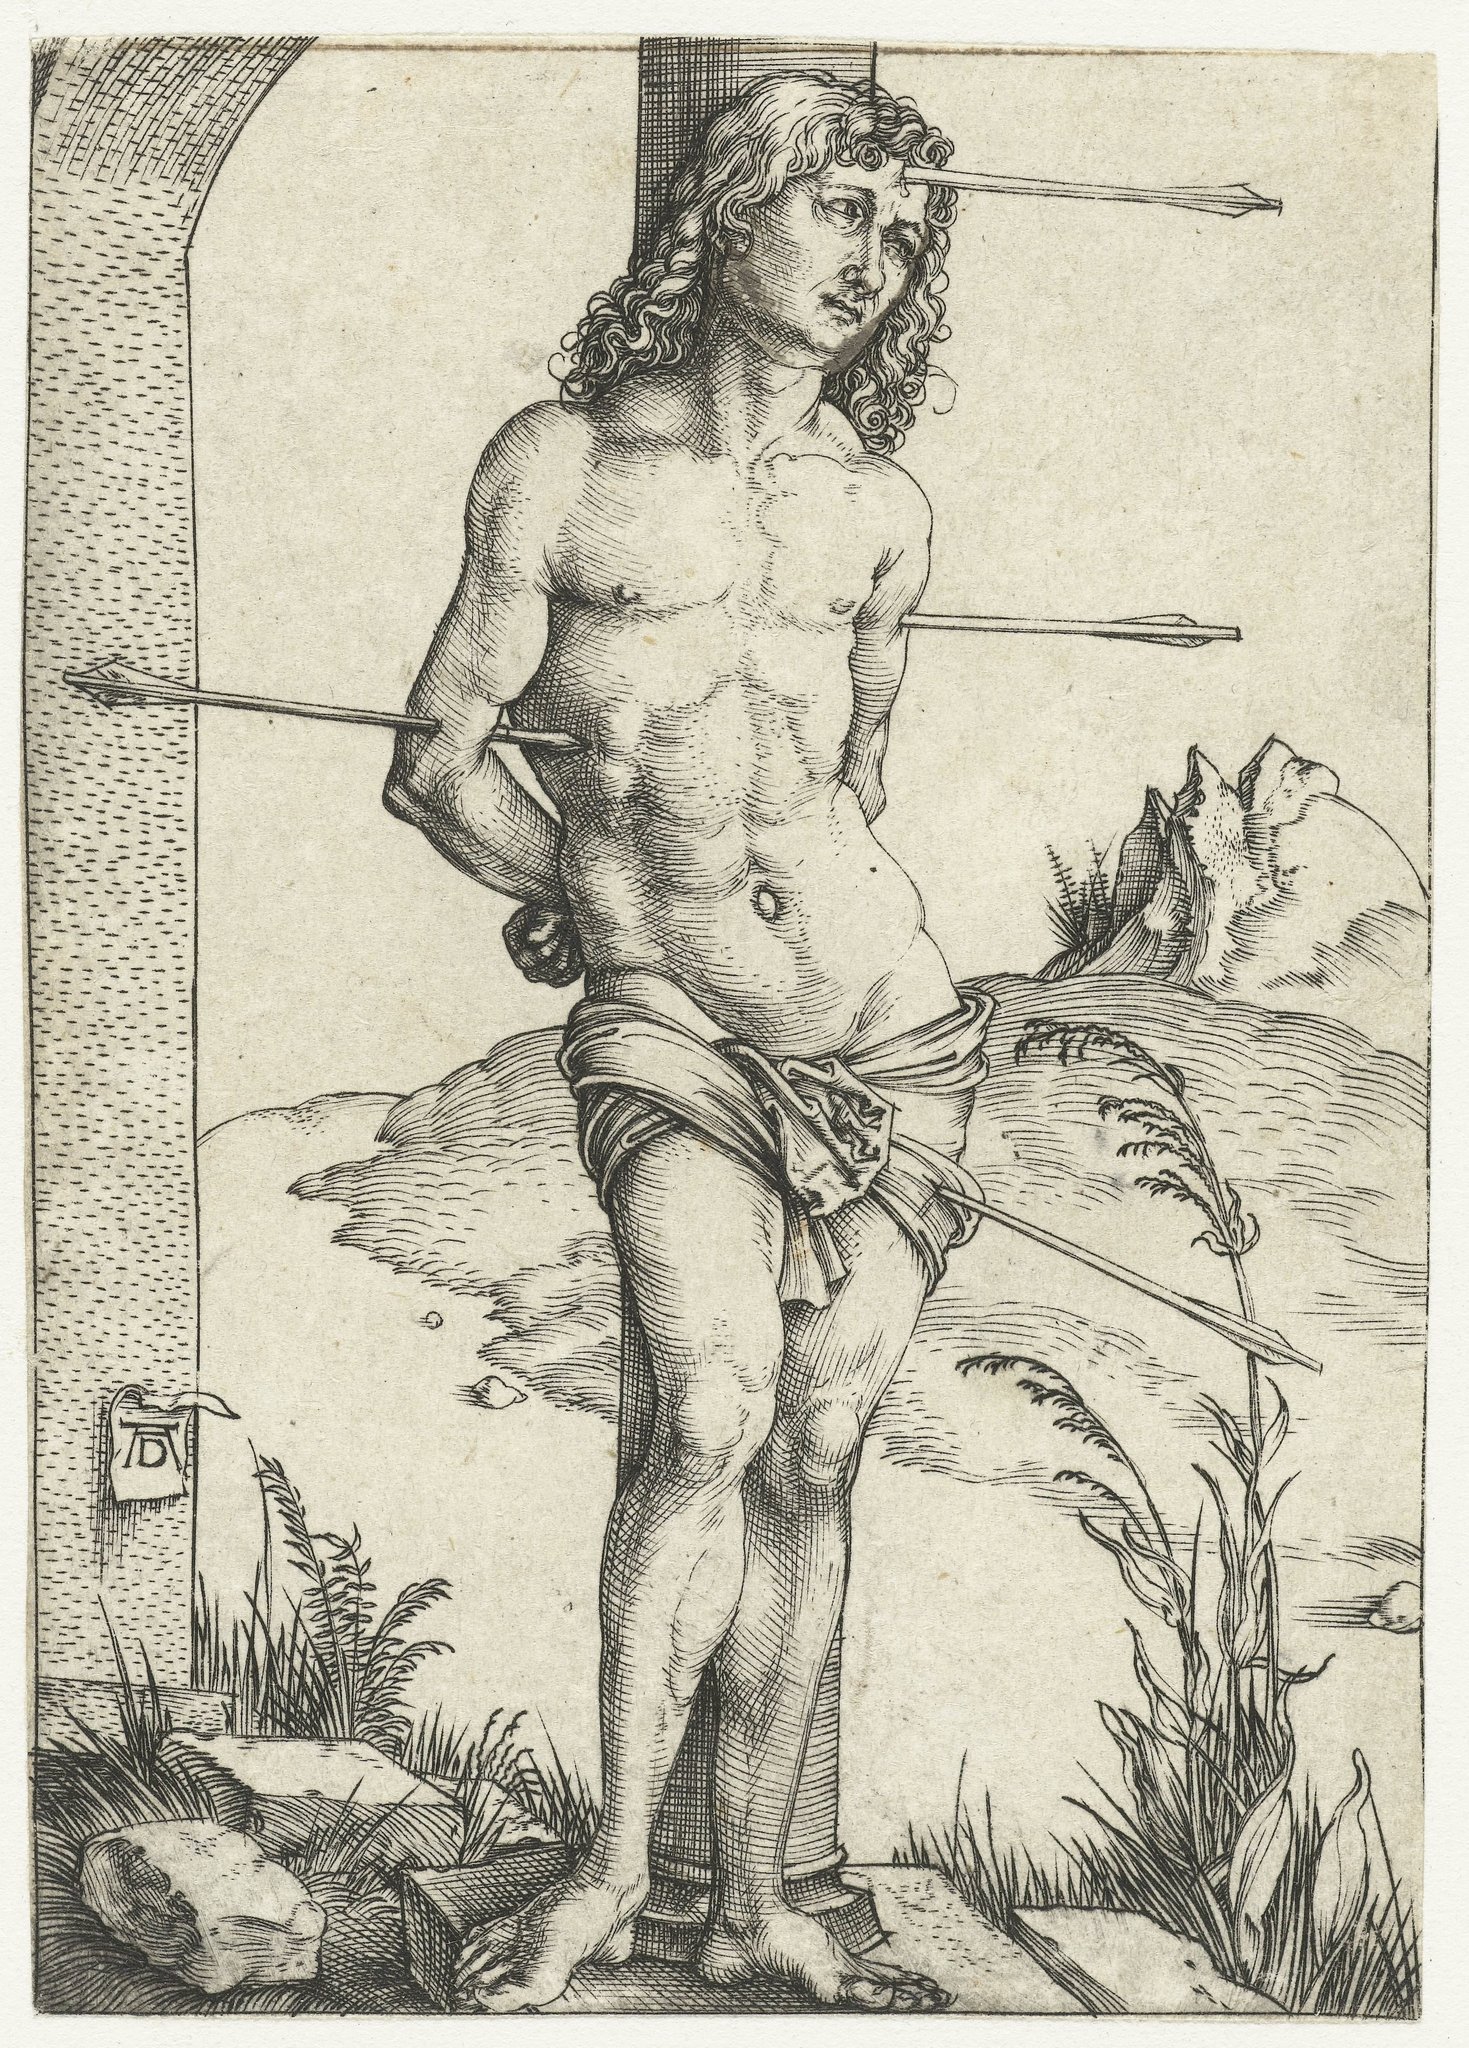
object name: print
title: Heilige Sebastiaan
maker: albrecht dürer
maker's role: draughtsman, painter, print maker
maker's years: 1471-1528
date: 1497-1501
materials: paper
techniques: engraving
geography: nuremberg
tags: st. sebastian, tied to a tree or a pillar, is pierced by arrows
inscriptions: collector's mark: Lugt 2228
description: De Heilige Sebastiaan, gebonden aan een pilaar, pijlen in zijn lichaam.